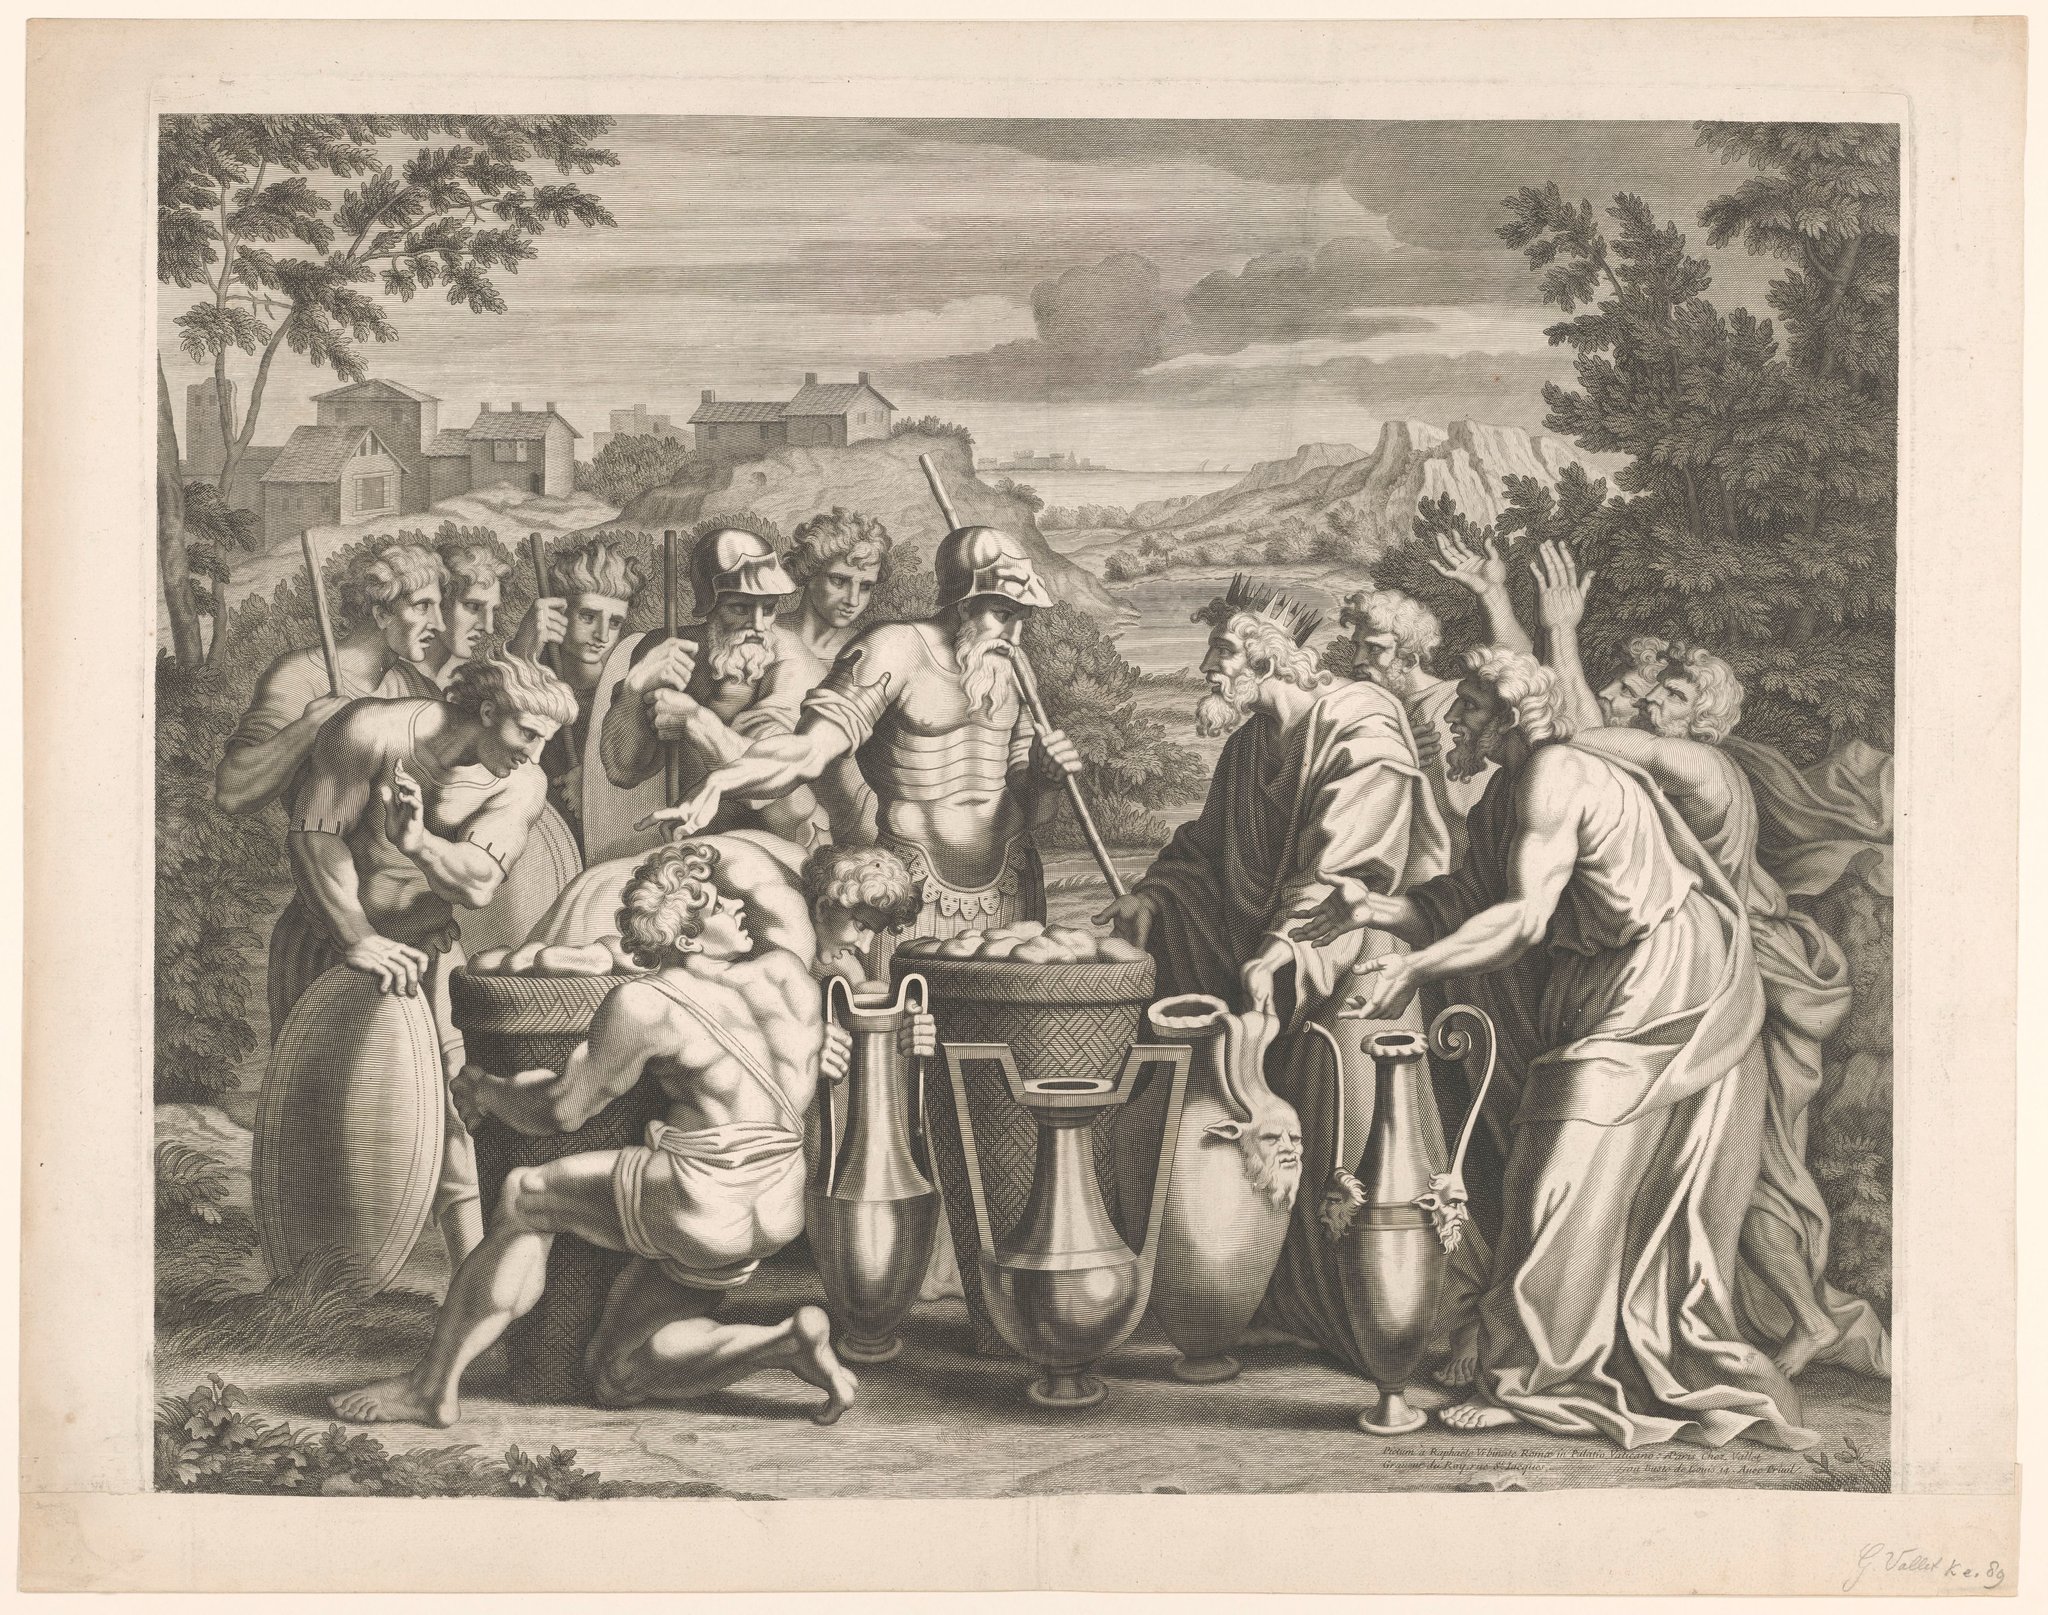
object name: print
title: Abraham en Melchisedek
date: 1642-1704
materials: paper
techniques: engraving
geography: paris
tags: abraham gives melchizedek a tenth of the booty he has recovered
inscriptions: collector's mark: Lugt 240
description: Abraham biedt Melchisedek een tiende van de buit aan na een succesvolle veldslag.